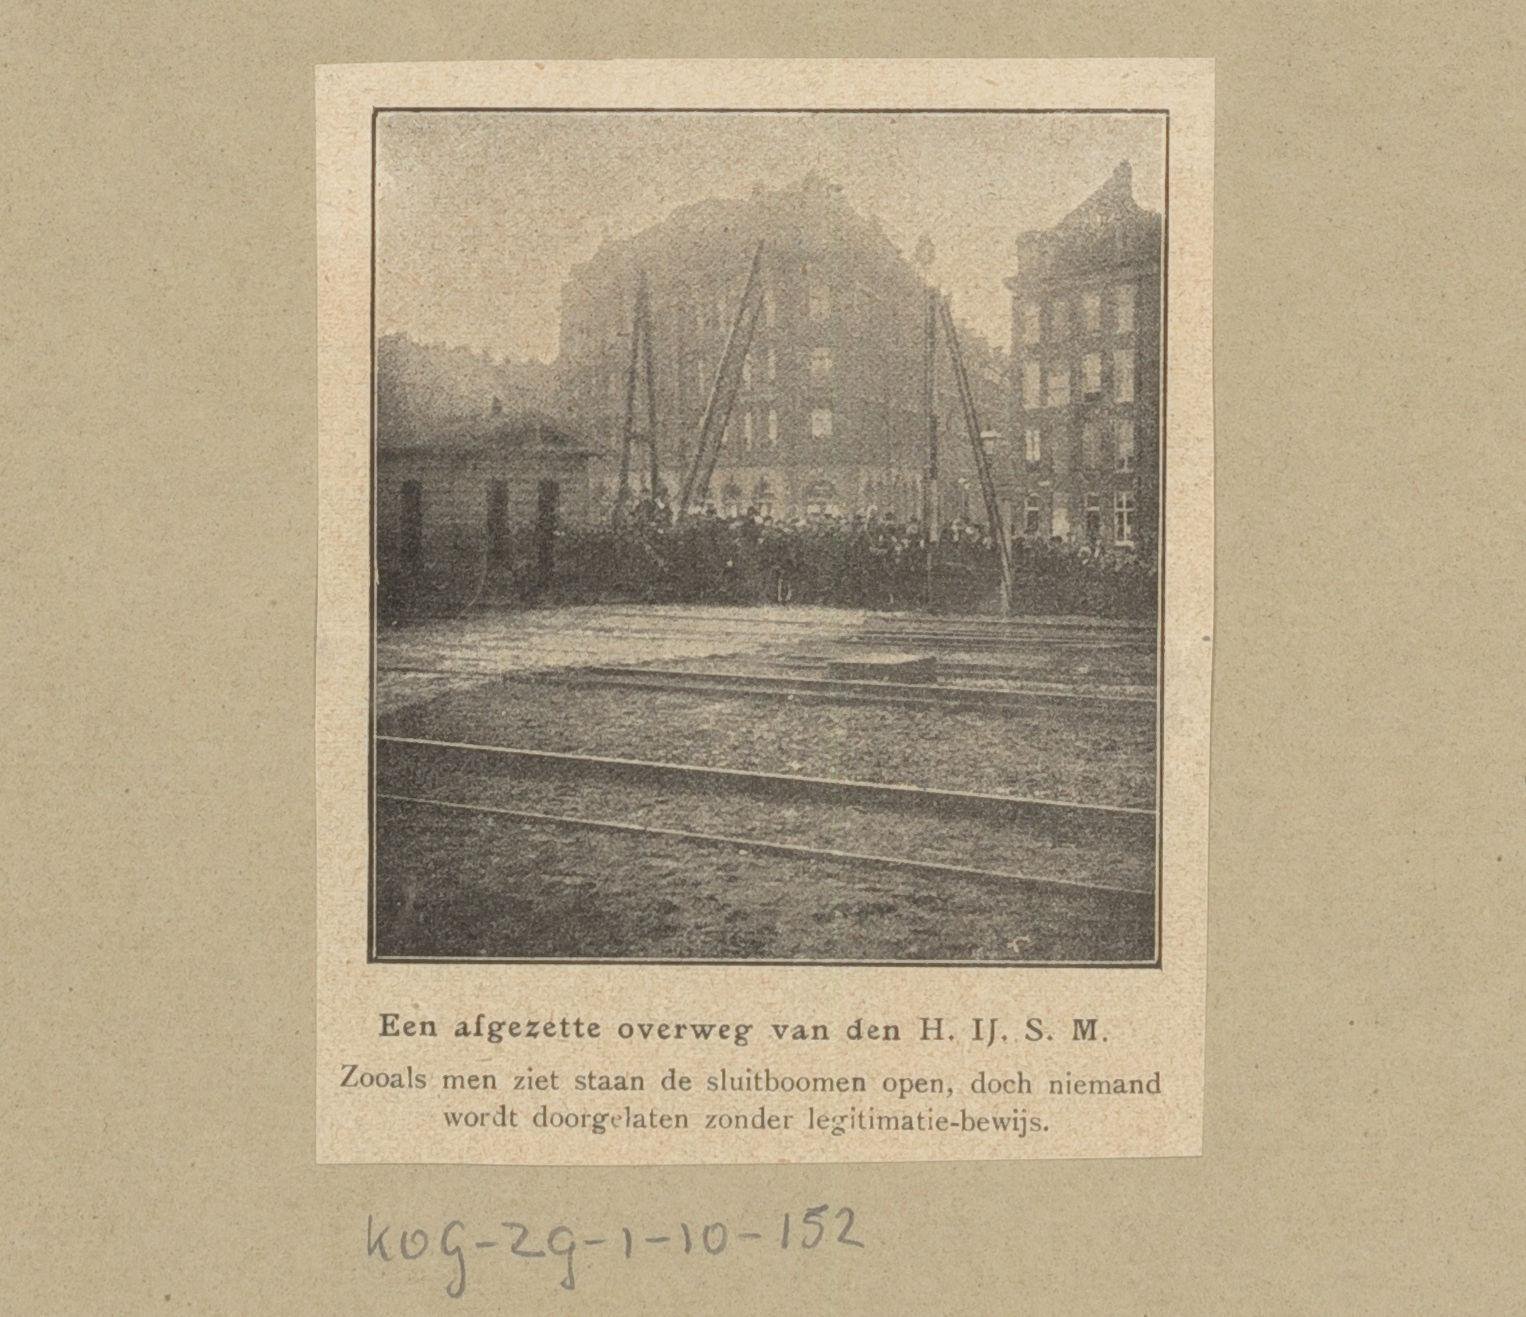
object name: photomechanical print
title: Afgezette spoorwegovergang tijdens de spoorwegstaking, 1903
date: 1903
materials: paper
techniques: letterpress printing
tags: rack railway, strike (political demonstration), amsterdam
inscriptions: collector's mark: Lugt 1641, stamp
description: Afgezette spoorwegovergang van de Hollandsche IJzeren Spoorweg-Maatschappij tijdens de spoorwegstaking van 1903. Door de stakingen wilde het spoorwegpersoneel het recht verkrijgen zich te mogen organiseren in een vakbond, onderhandelingen te voeren en te staken. Onderaan de tekst: Zooals men ziet staan de sluitboomen open, niemand wordt doorgelaten zonder legitimatie-bewijs. Onderwerpsrubrieken binnen de Atlas Zeden en Gewoonten: Handel, nijverheid en verkeer, Vervoermiddelen te land en te water, vervoermiddelen te land, Spoorwegen.